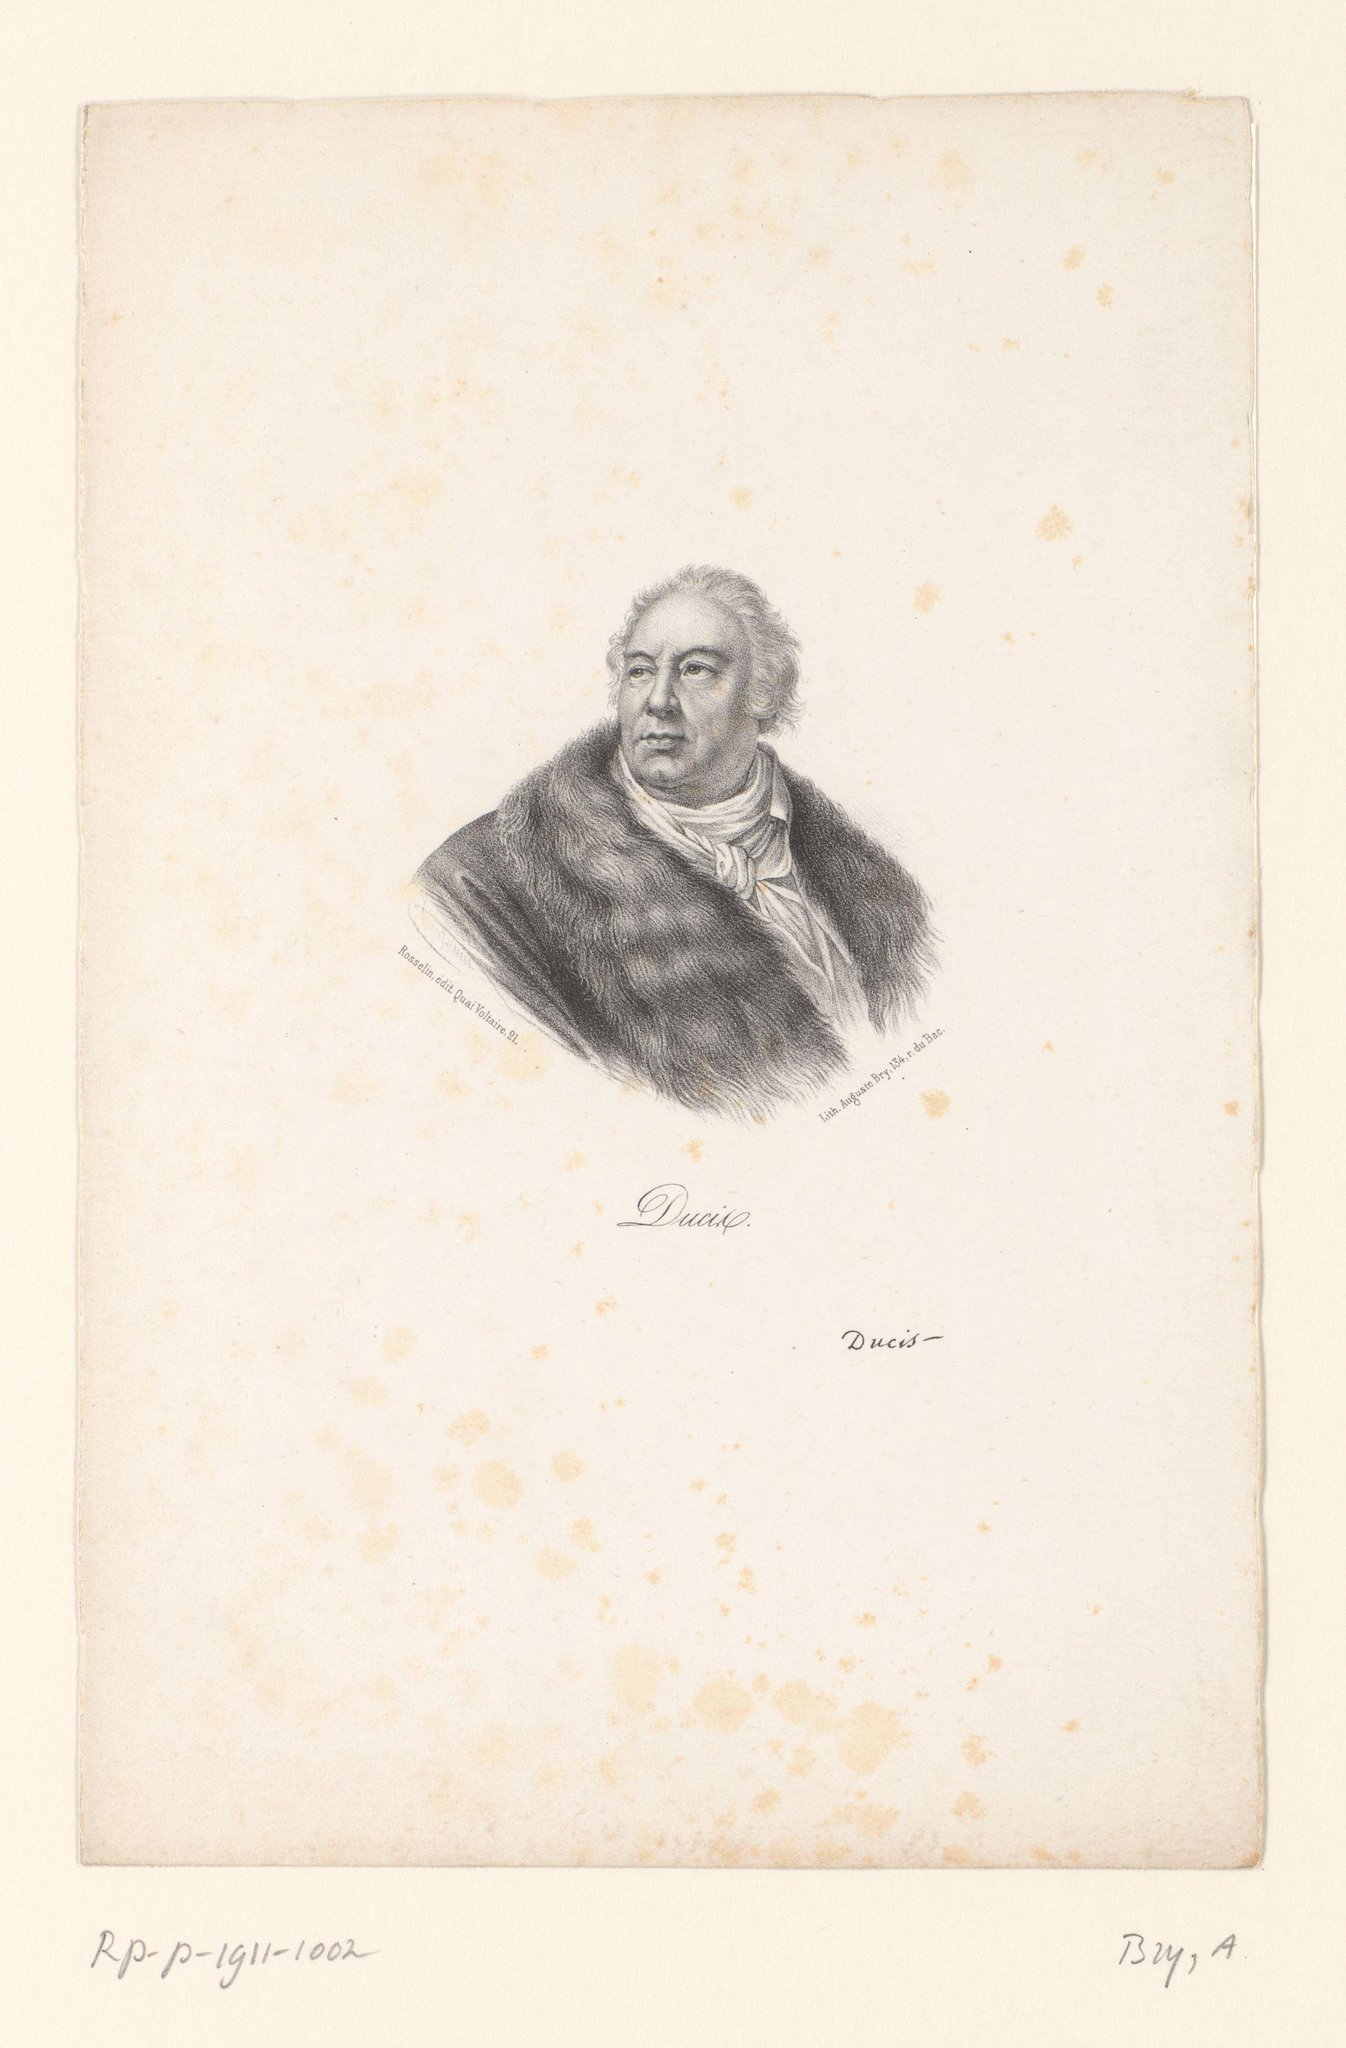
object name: print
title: Portret van de schrijver Jean-François Ducis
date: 1830-1861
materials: paper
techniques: lithograph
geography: paris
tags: historical persons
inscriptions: collector's mark: Lugt 2228a